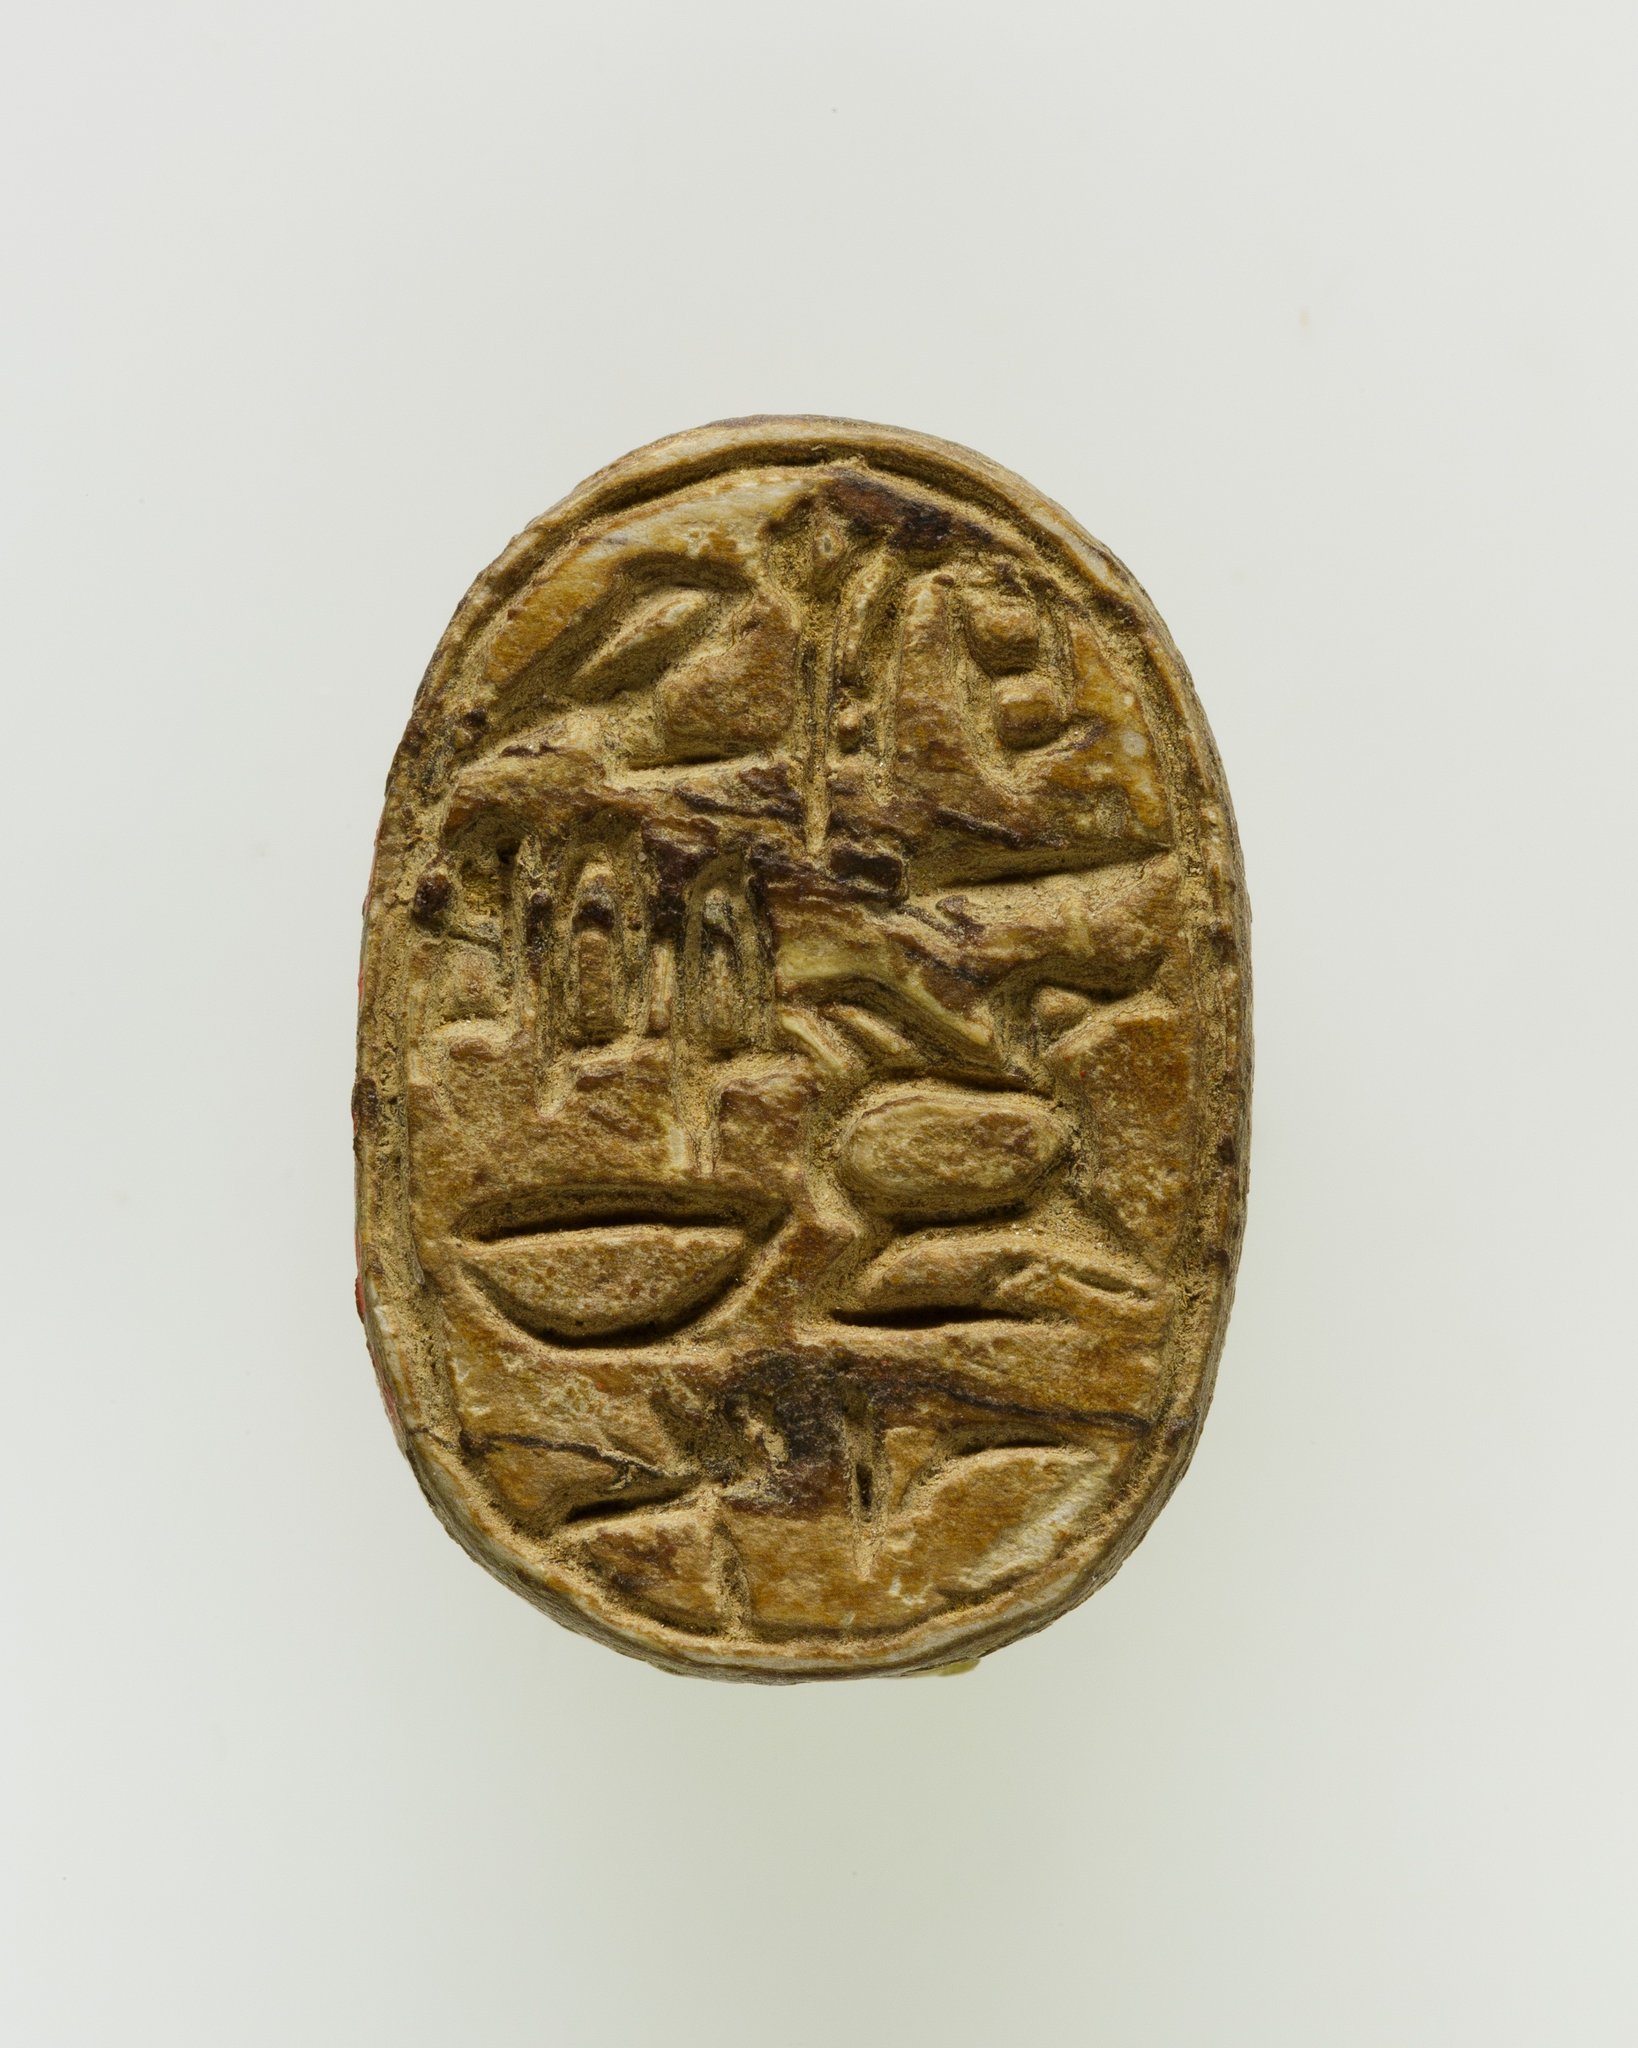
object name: scarab, official, private name and title, funerary epithet, ay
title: Scarab of an Official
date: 1760-1670 BCE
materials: stone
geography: egypt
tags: scarabs